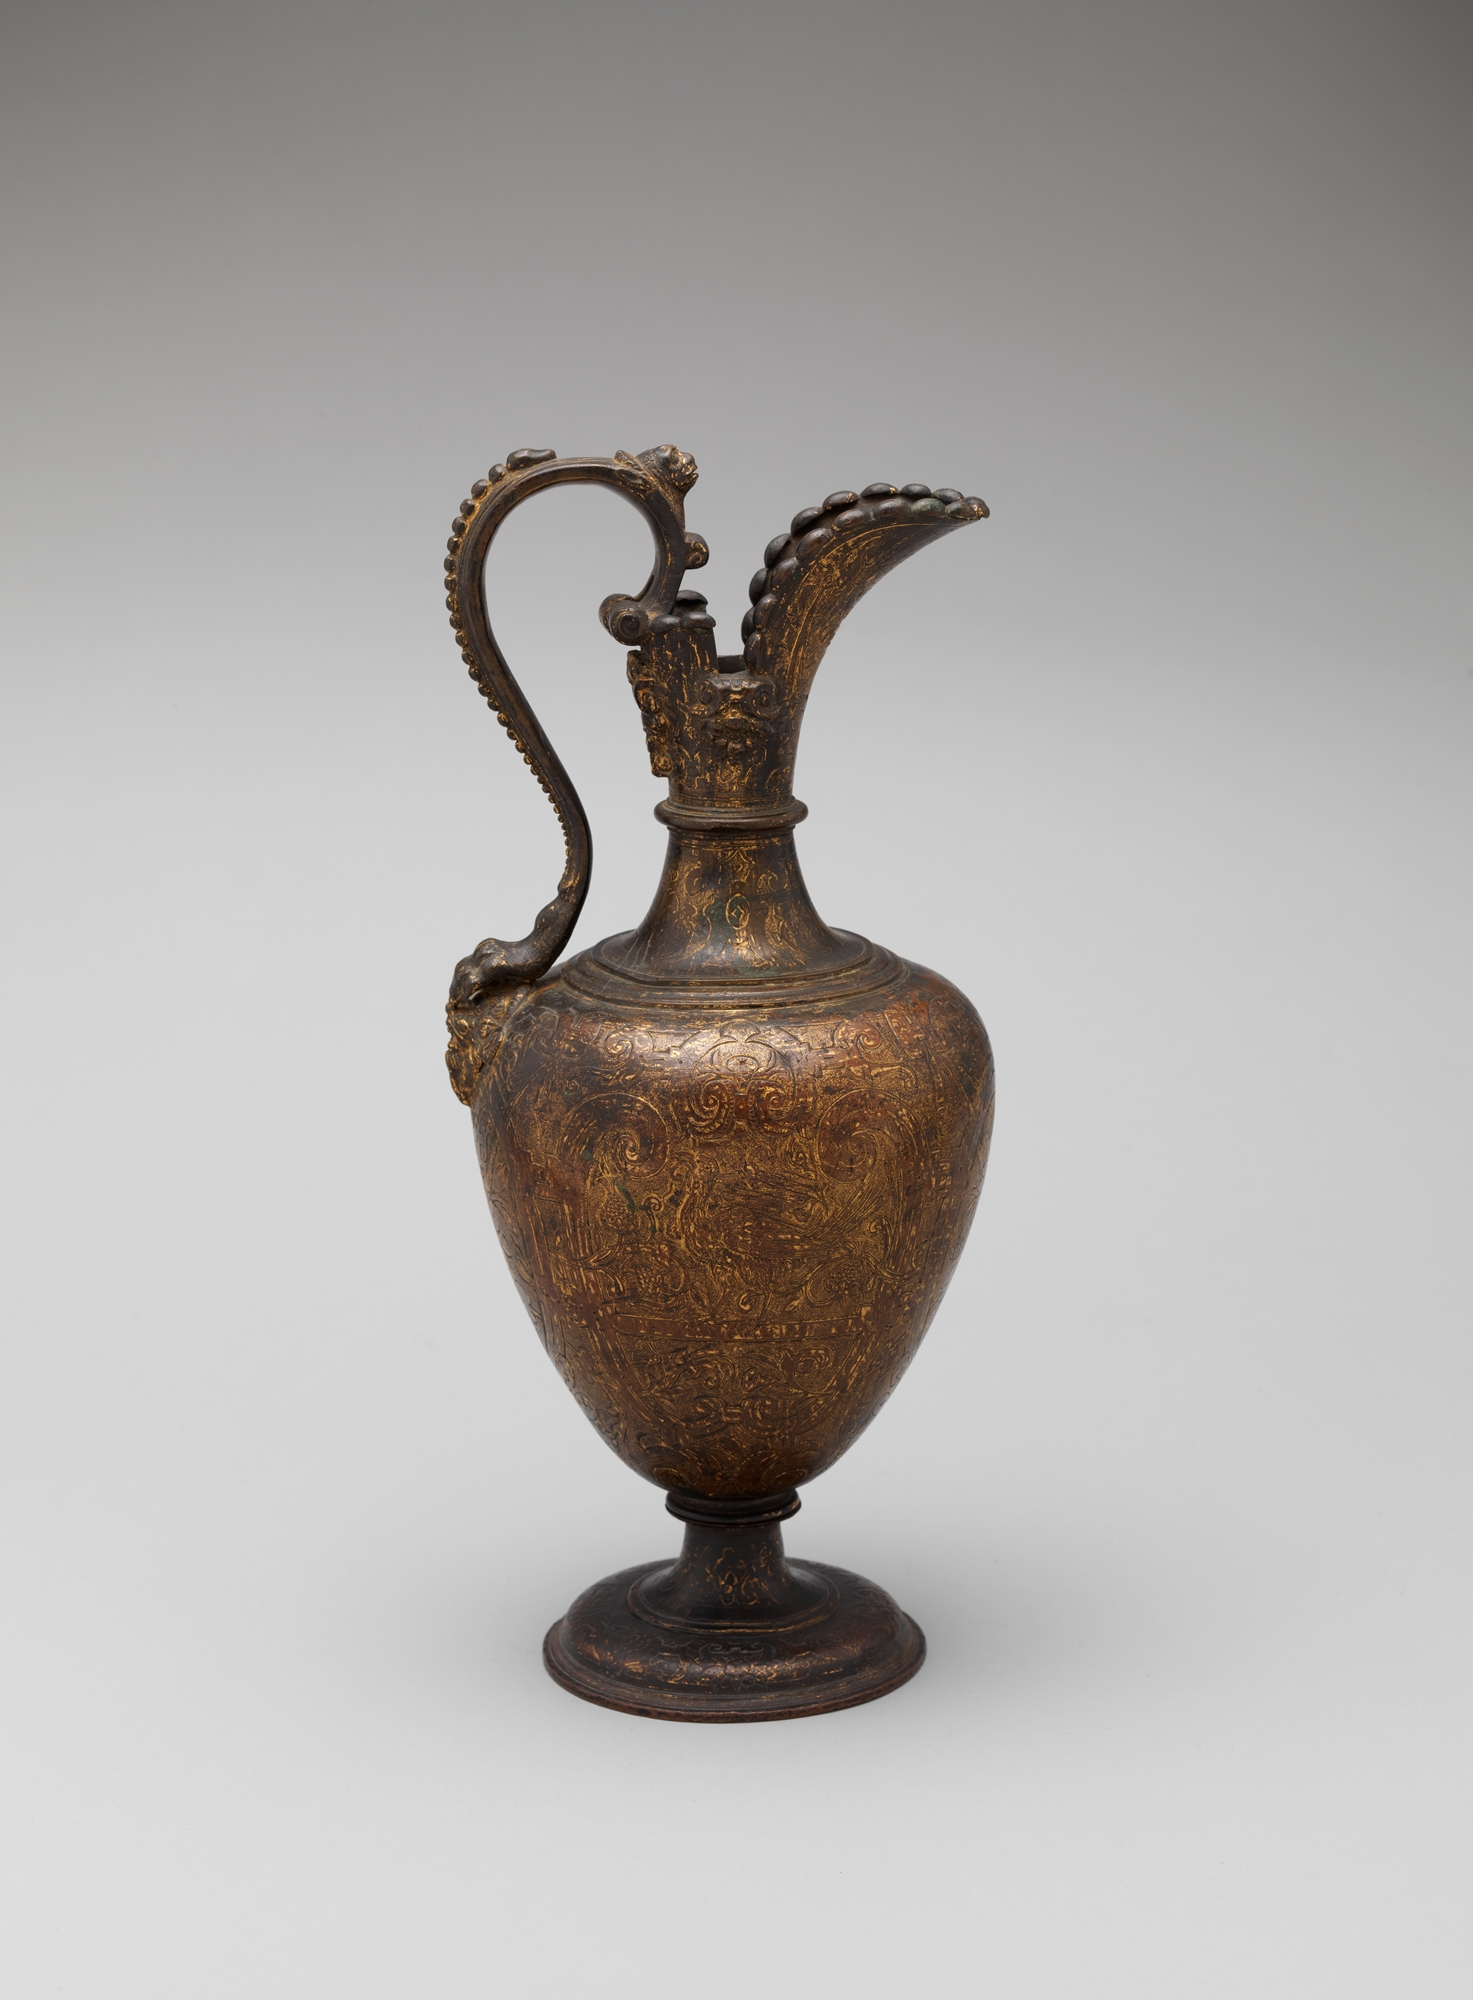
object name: ewer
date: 1501-1600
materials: gilt bronze